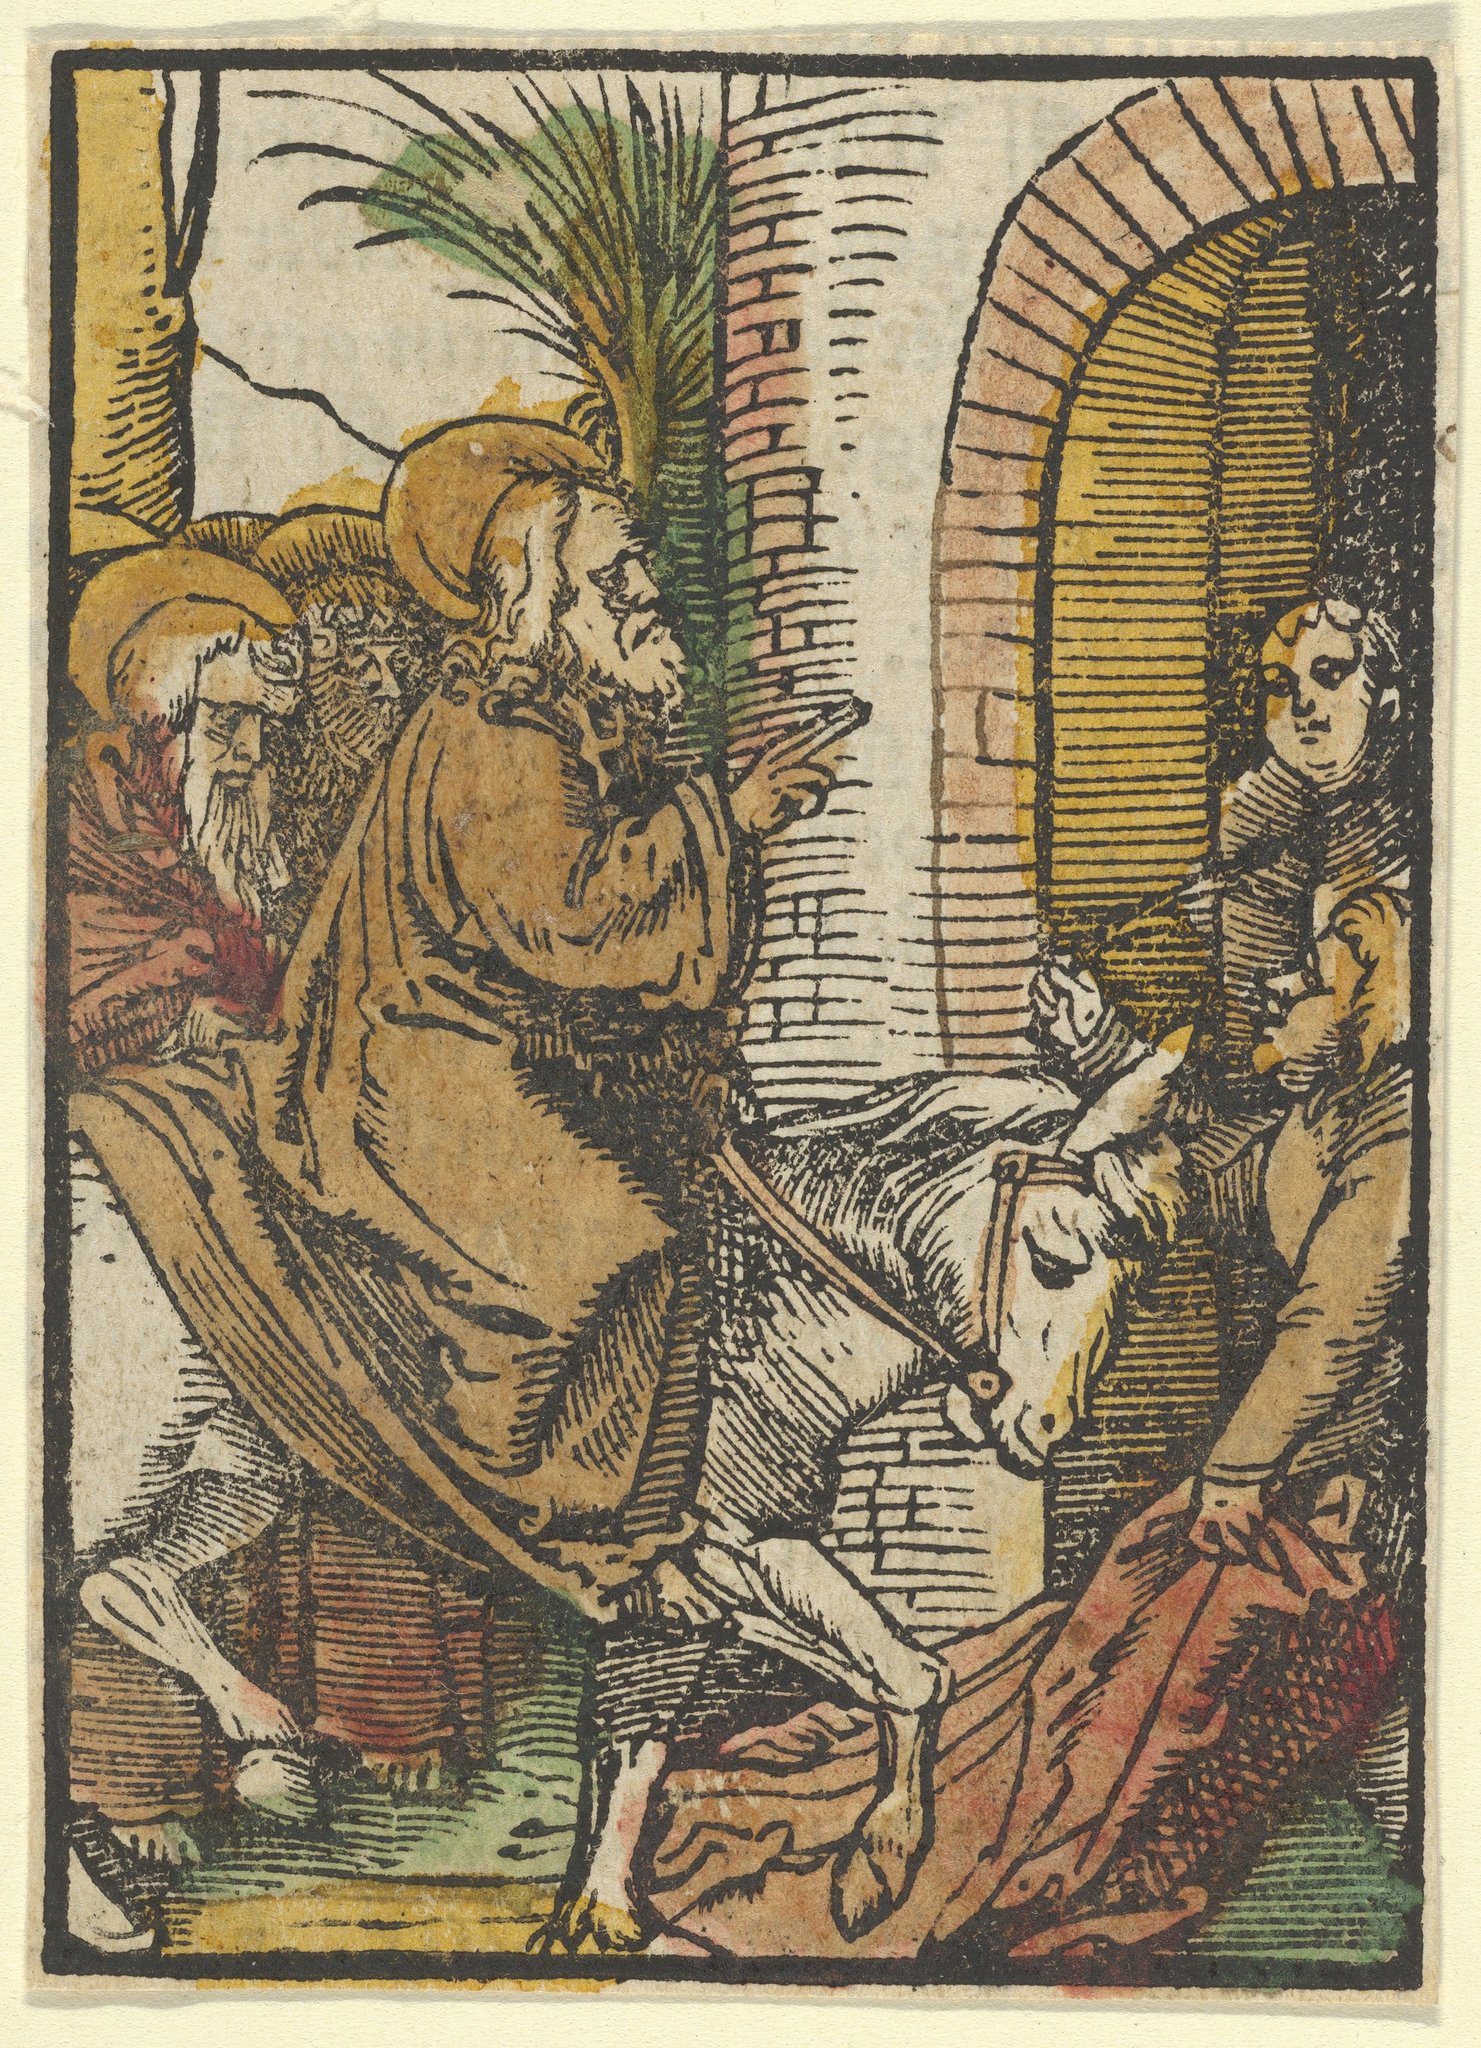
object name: print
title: The Entry into Jerusalem, from Das Plenarium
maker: hans schäufelein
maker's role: artist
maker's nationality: german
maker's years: 1480-1540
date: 1517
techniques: hand coloring, woodcut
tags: men,donkeys,jesus,saints